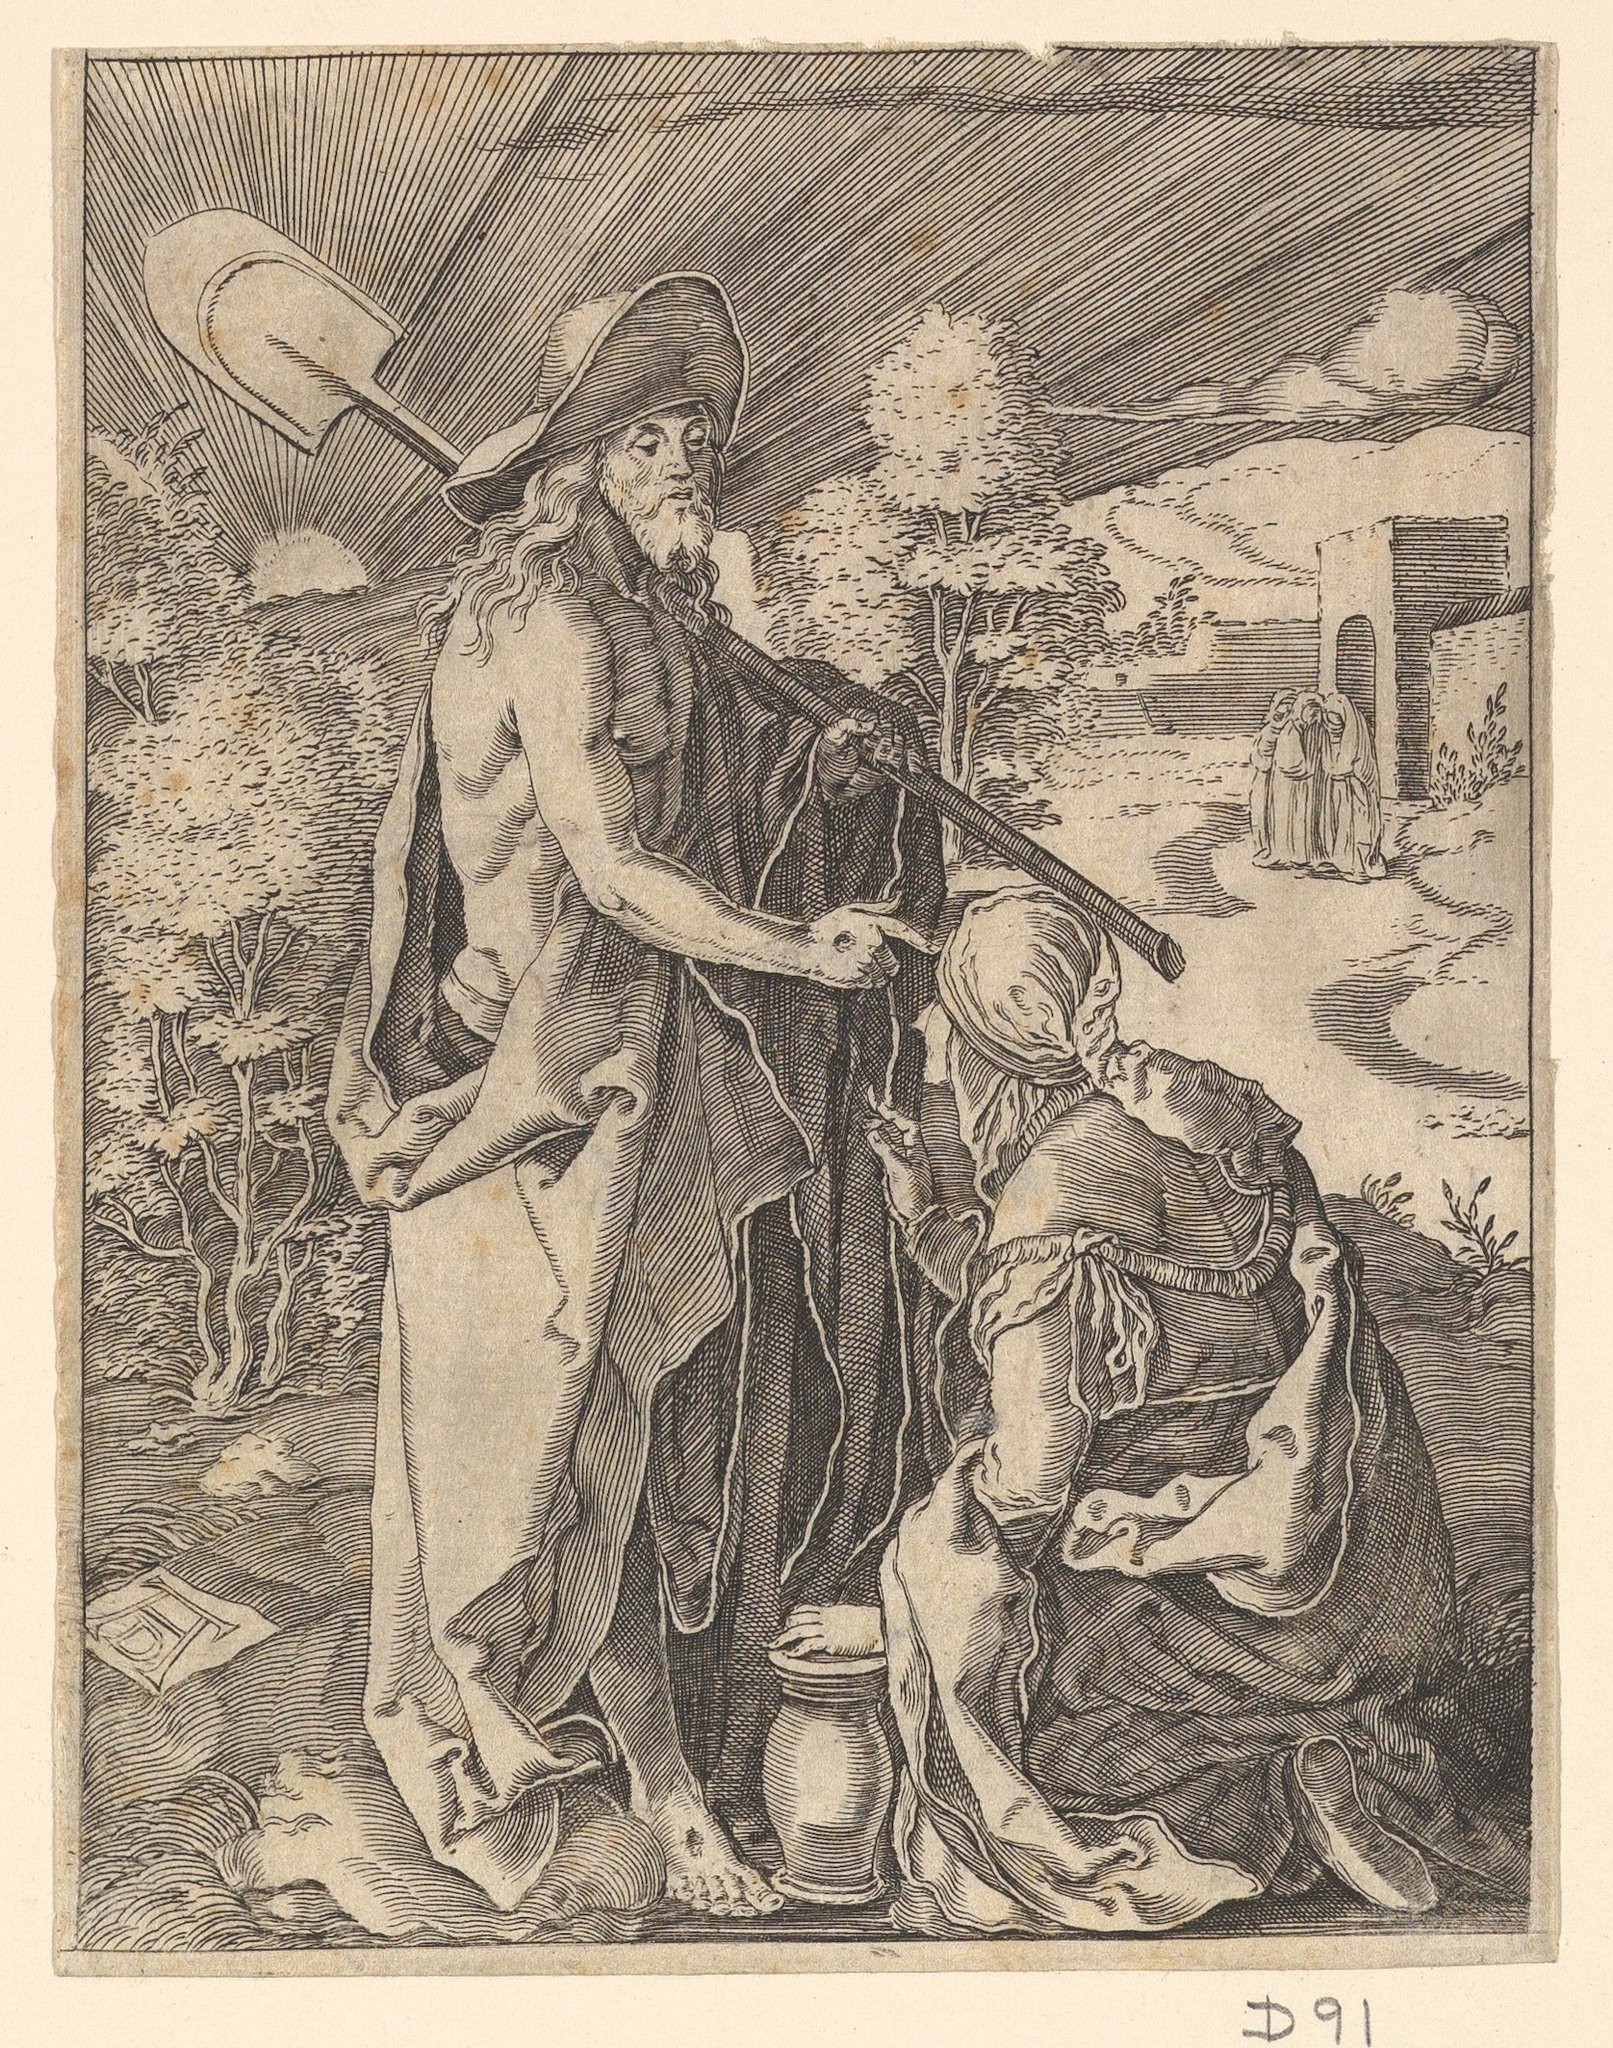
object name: print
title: Engraved copies of The Little Passion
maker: albrecht dürer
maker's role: artist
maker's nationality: german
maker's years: 1471-1528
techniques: engraving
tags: christ,tools